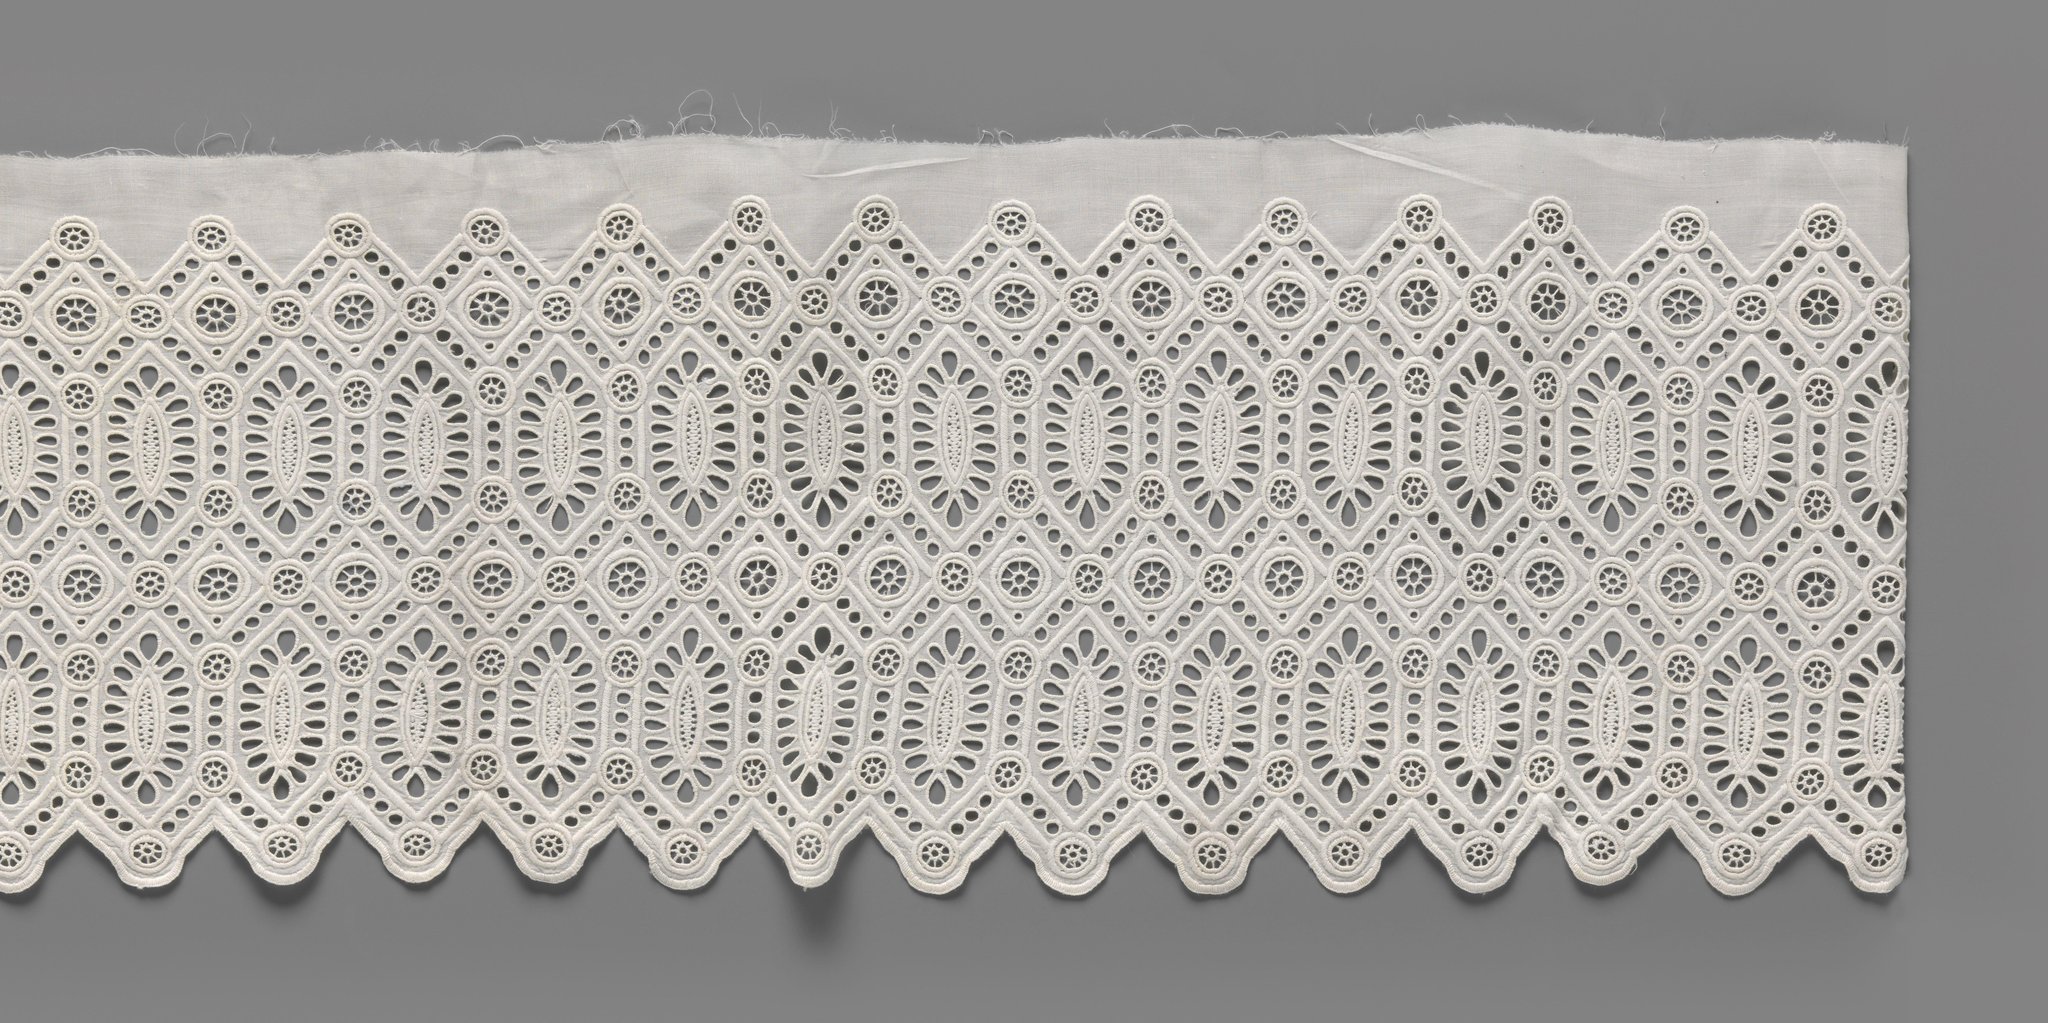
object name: strip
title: Strook katoen met kantborduurwerk met een geometrisch patroon van zeshoeken tussen ruiten en zigzag-schulpen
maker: c.i. bosch reitz-teding van berkhout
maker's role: kantwerkster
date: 1860-1880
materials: cotton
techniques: weave, embroidery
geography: amsterdam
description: Strook naturelkleurige katoen met kantborduurwerk: Engels borduurwerk. Dicht op elkaar aansluitend geometrisch patroon met twee rijen ruiten gevormd door geborduurde rechte zigzag-banen. De onderste (derde) rij is gehalveerd waardoor zigzag-schulpen ontstaan. Tussen de banen met ruiten en de zigzag-schulpen worden langwerpige zeshoekige velden gevormd met in elke zeshoek een margriet met opengewerkte bloemblaadjes en een langgerekt spitsovaal bloemhart. In de zigzag-banen rijen met opengewerkte cirkeltjes en op elk kruispunt tussen alle velden staat een opengewerkt cirkeltje met naaldkantsteken erin.